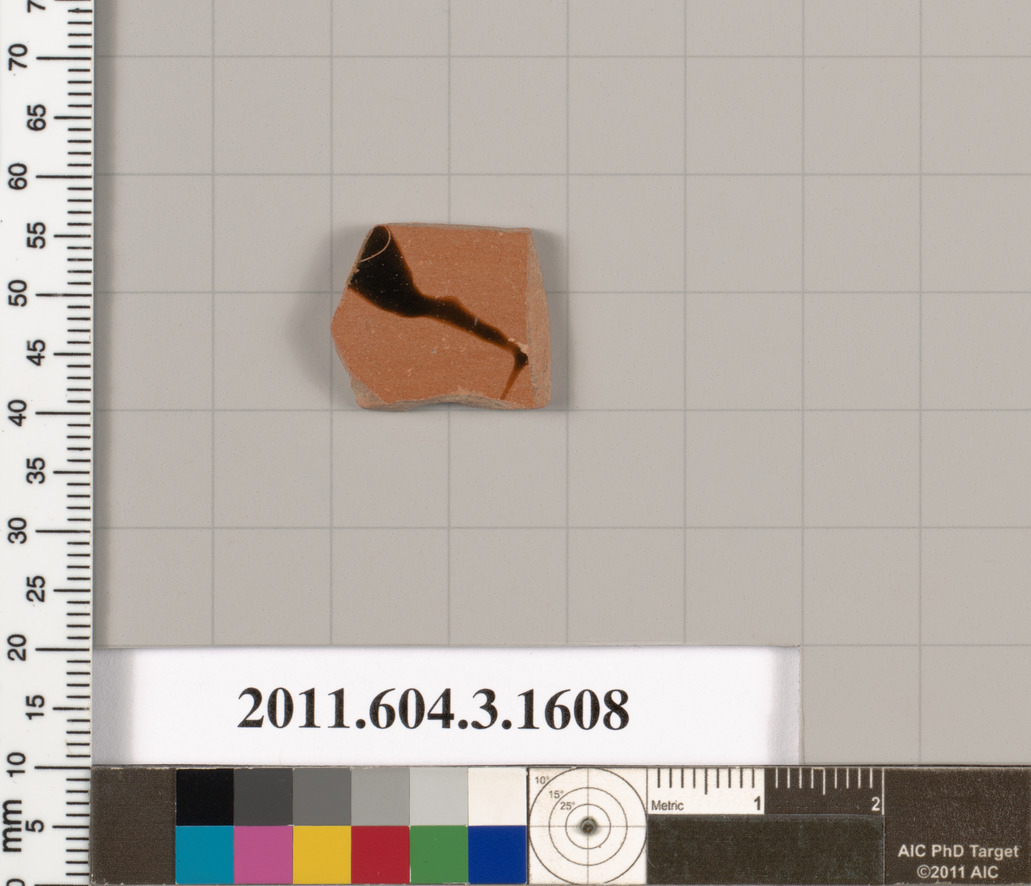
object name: kylix fragment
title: Terracotta fragment of a kylix: Band cup (drinking cup)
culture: greek, attic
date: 550-526 BCE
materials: terracotta